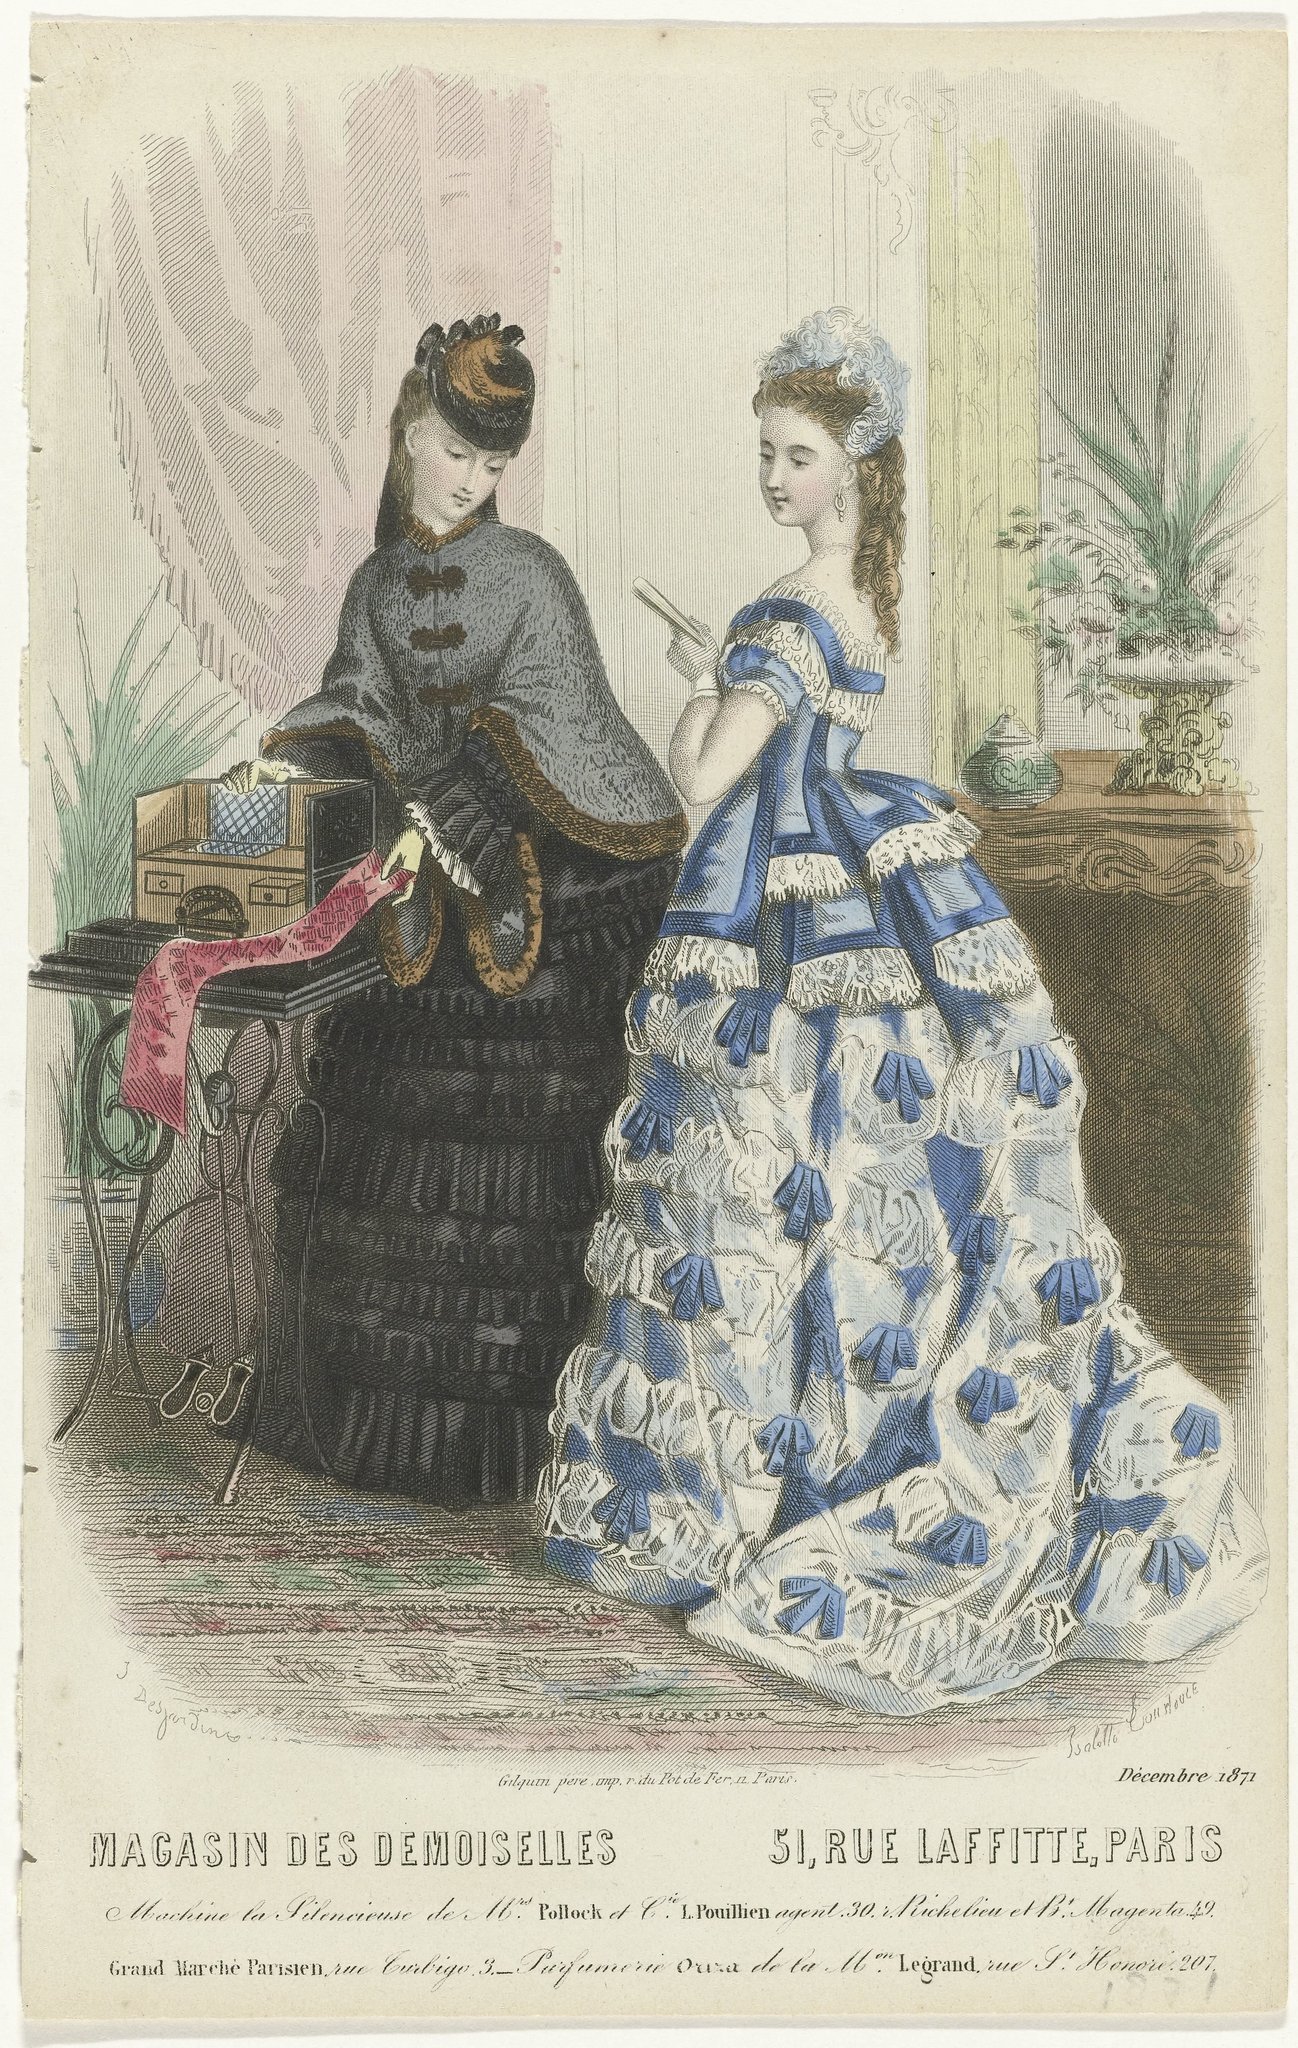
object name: fashion print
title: Magasin des Demoiselles, décembre 1871 : Machine la Silencieus (...)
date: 1871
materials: paper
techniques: engraving, hand coloring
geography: paris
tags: ear-rings (+ women's clothes), sewing machine, coat (+ women's clothes), head-gear (+ women's clothes), fashion plates, gloves, mittens, etc. (+ women's clothes), dress, gown (+ women's clothes), fan (+ women's clothes)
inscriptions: caption: ‘Machine la Silencieuse de Mrs Pollock et Cie L. Pouillien agent, r. Richelieu et Bt Magenta 49. Grand Marché Parisien, rue Turbigo.3 _ Parfumerie Oriza de la Mon Legrand, rue St Honoré.207.’, address: ‘51, rue Laffitte, Paris’, title: ‘Magasin des Demoiselles’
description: Twee vrouwen in interieur, de vouw met mantel toont de werking van de lockmachine. De andere vrouw is gekleed in een japon met queue. Onder de voorstelling enkele regels reclametekst voor verschillende producten. Prent uit het modetijdschrift Magasin des Demoiselles (1844-1896).